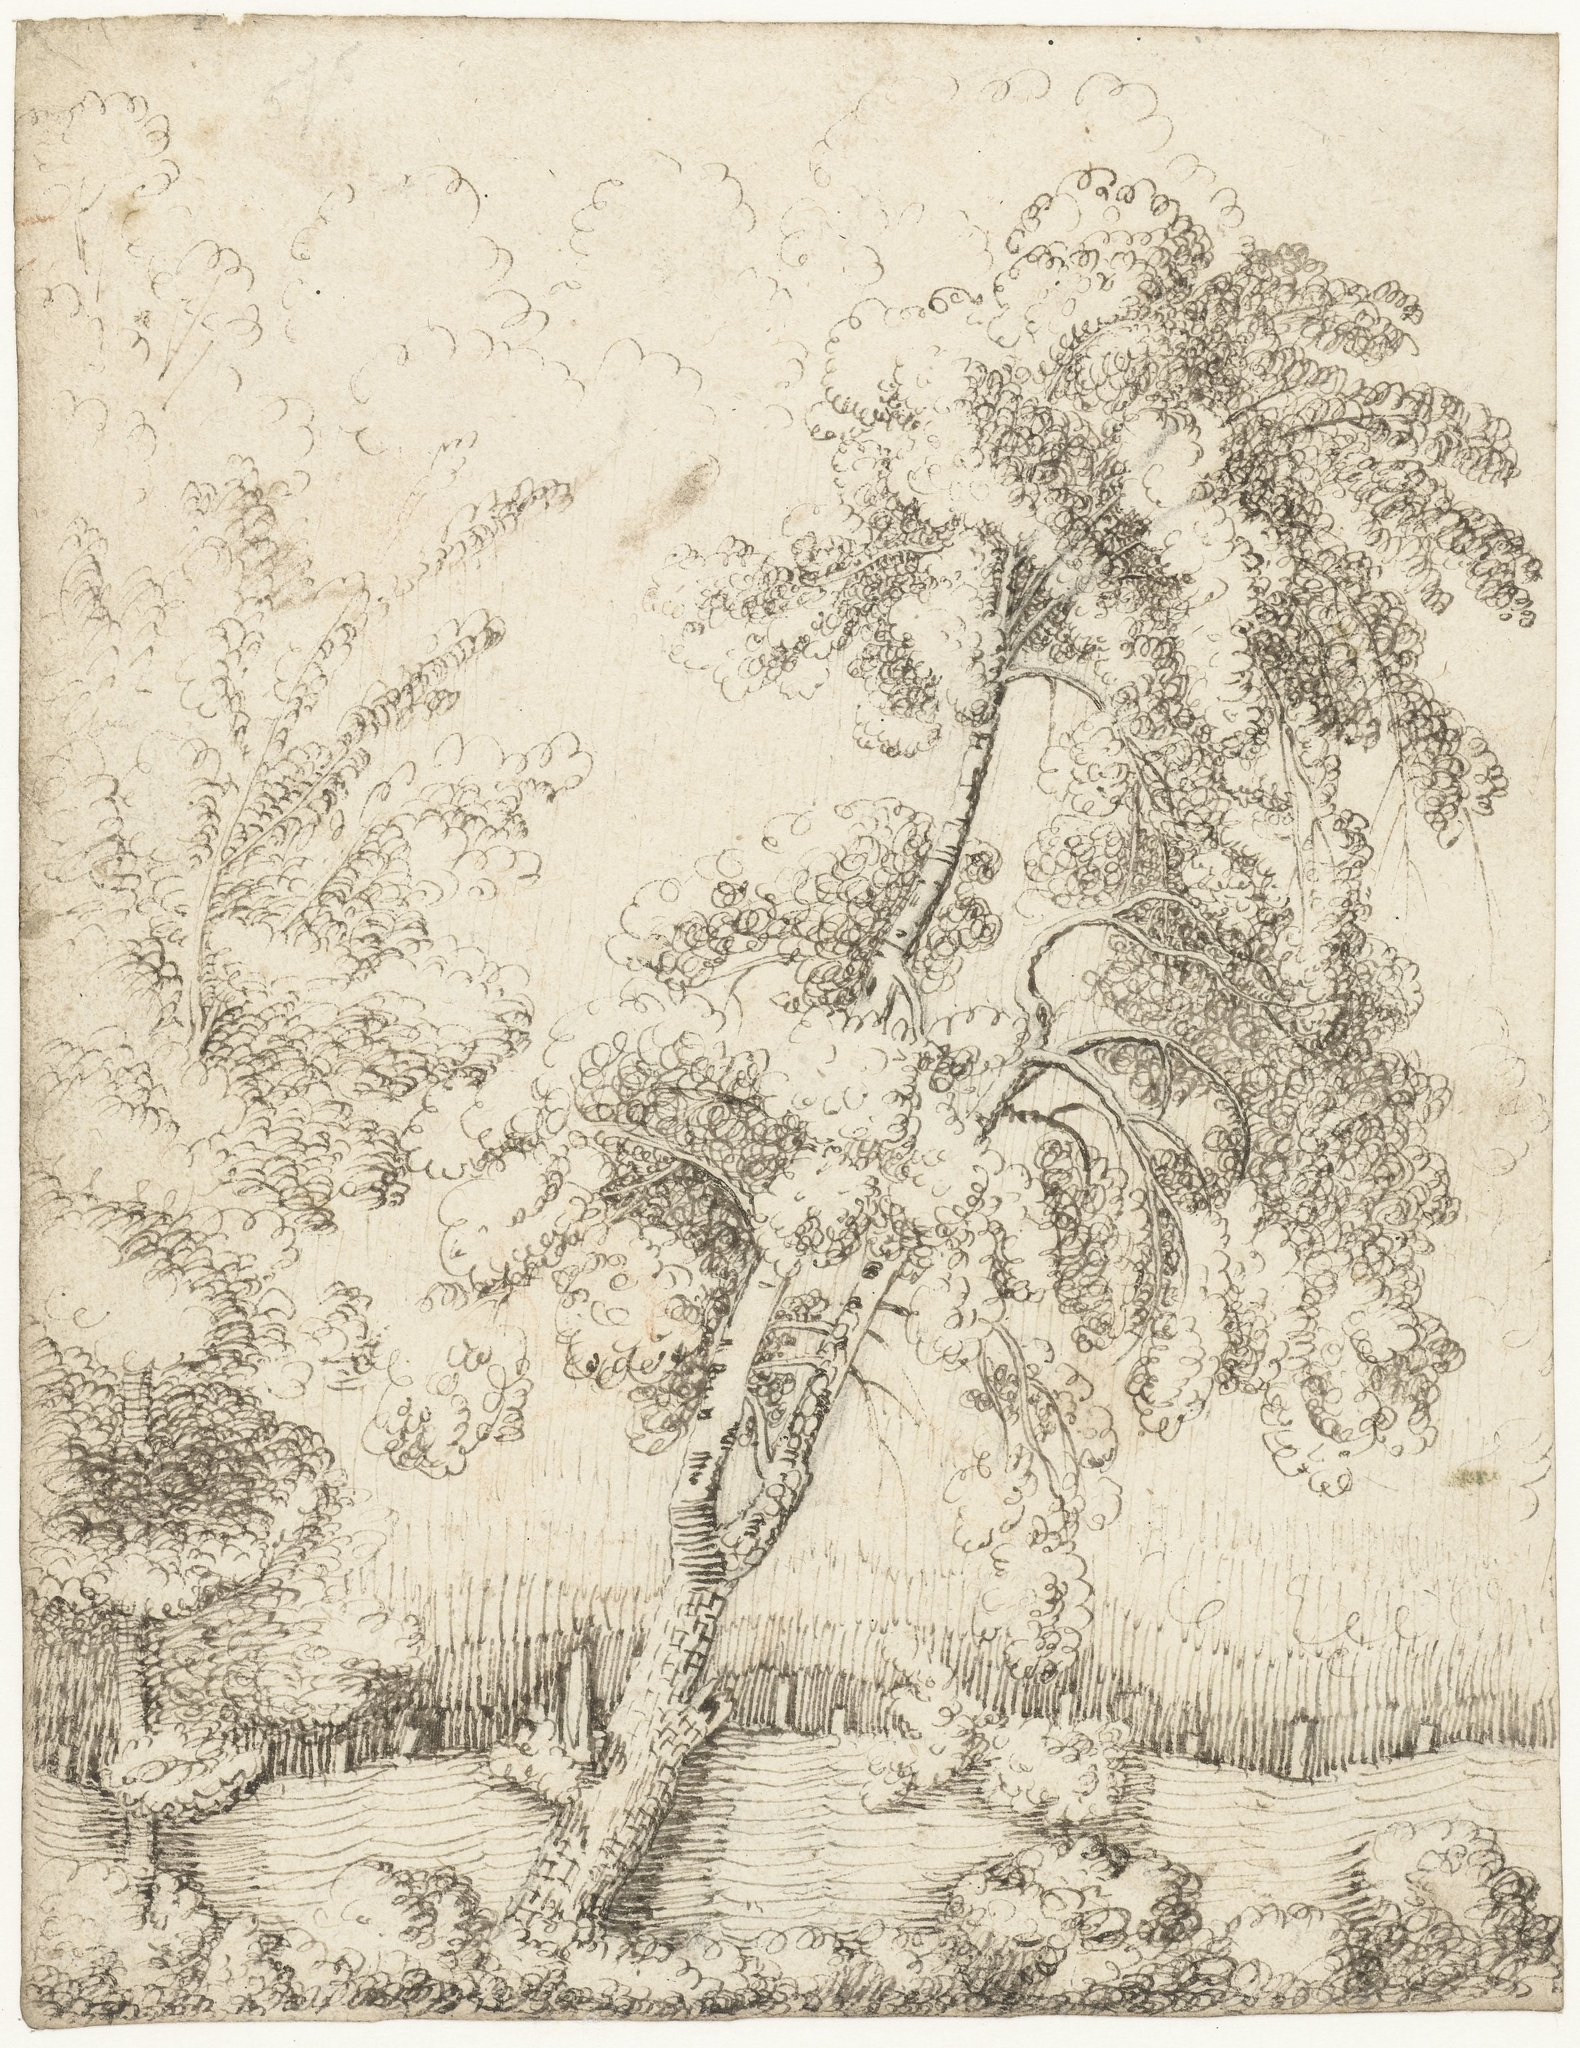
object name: drawing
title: Bomen bij een hekwerk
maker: gerard ter borch (i)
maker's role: draughtsman, print maker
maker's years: 1584-1662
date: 1620-1625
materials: chalk, ink, paper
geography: zwolle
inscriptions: signature: ‘Ger.ter Borch Sr.’